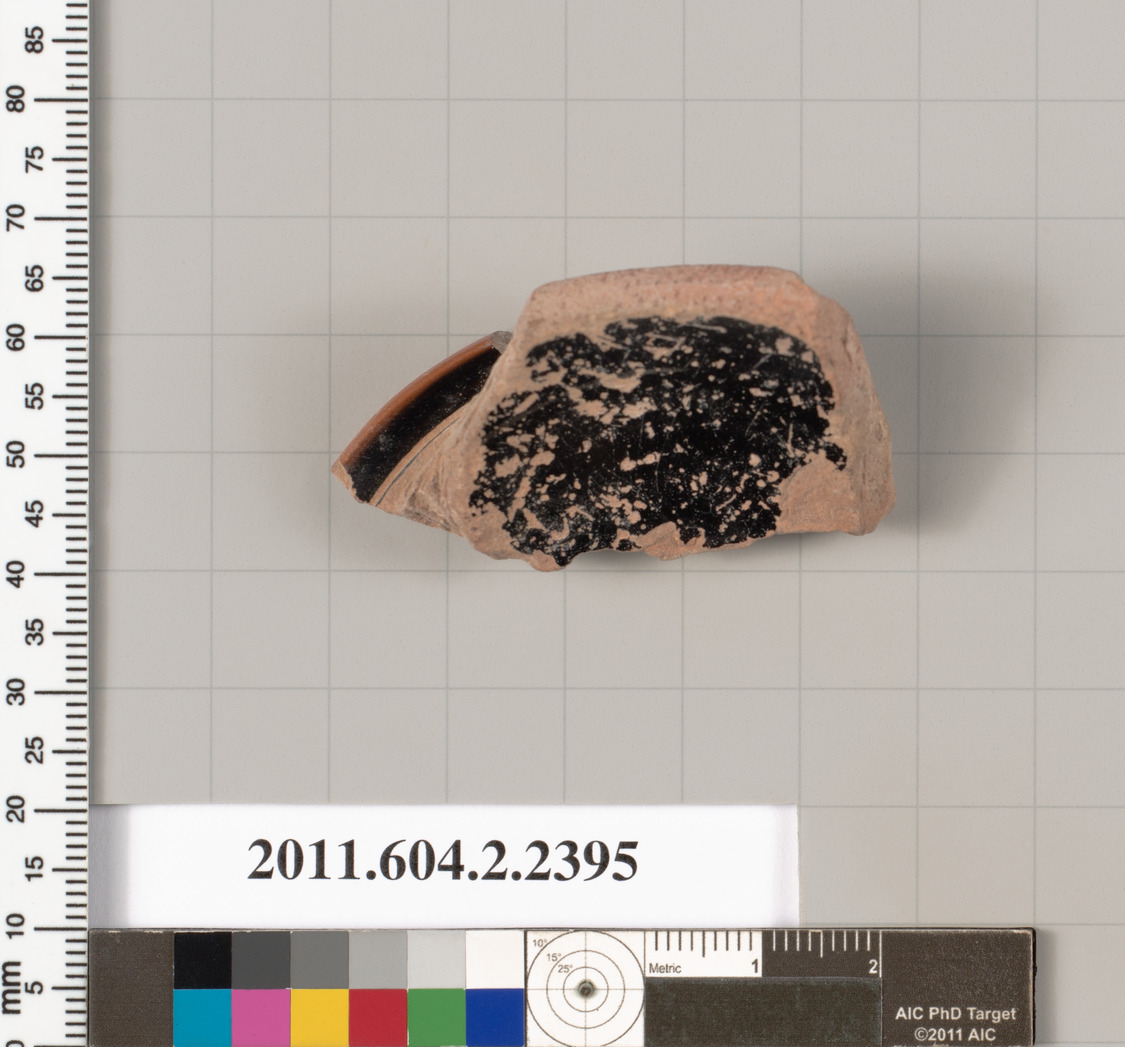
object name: skyphos fragment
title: Terracotta fragment of a skyphos (deep drinking cup)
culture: greek, attic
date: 475-451 BCE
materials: terracotta